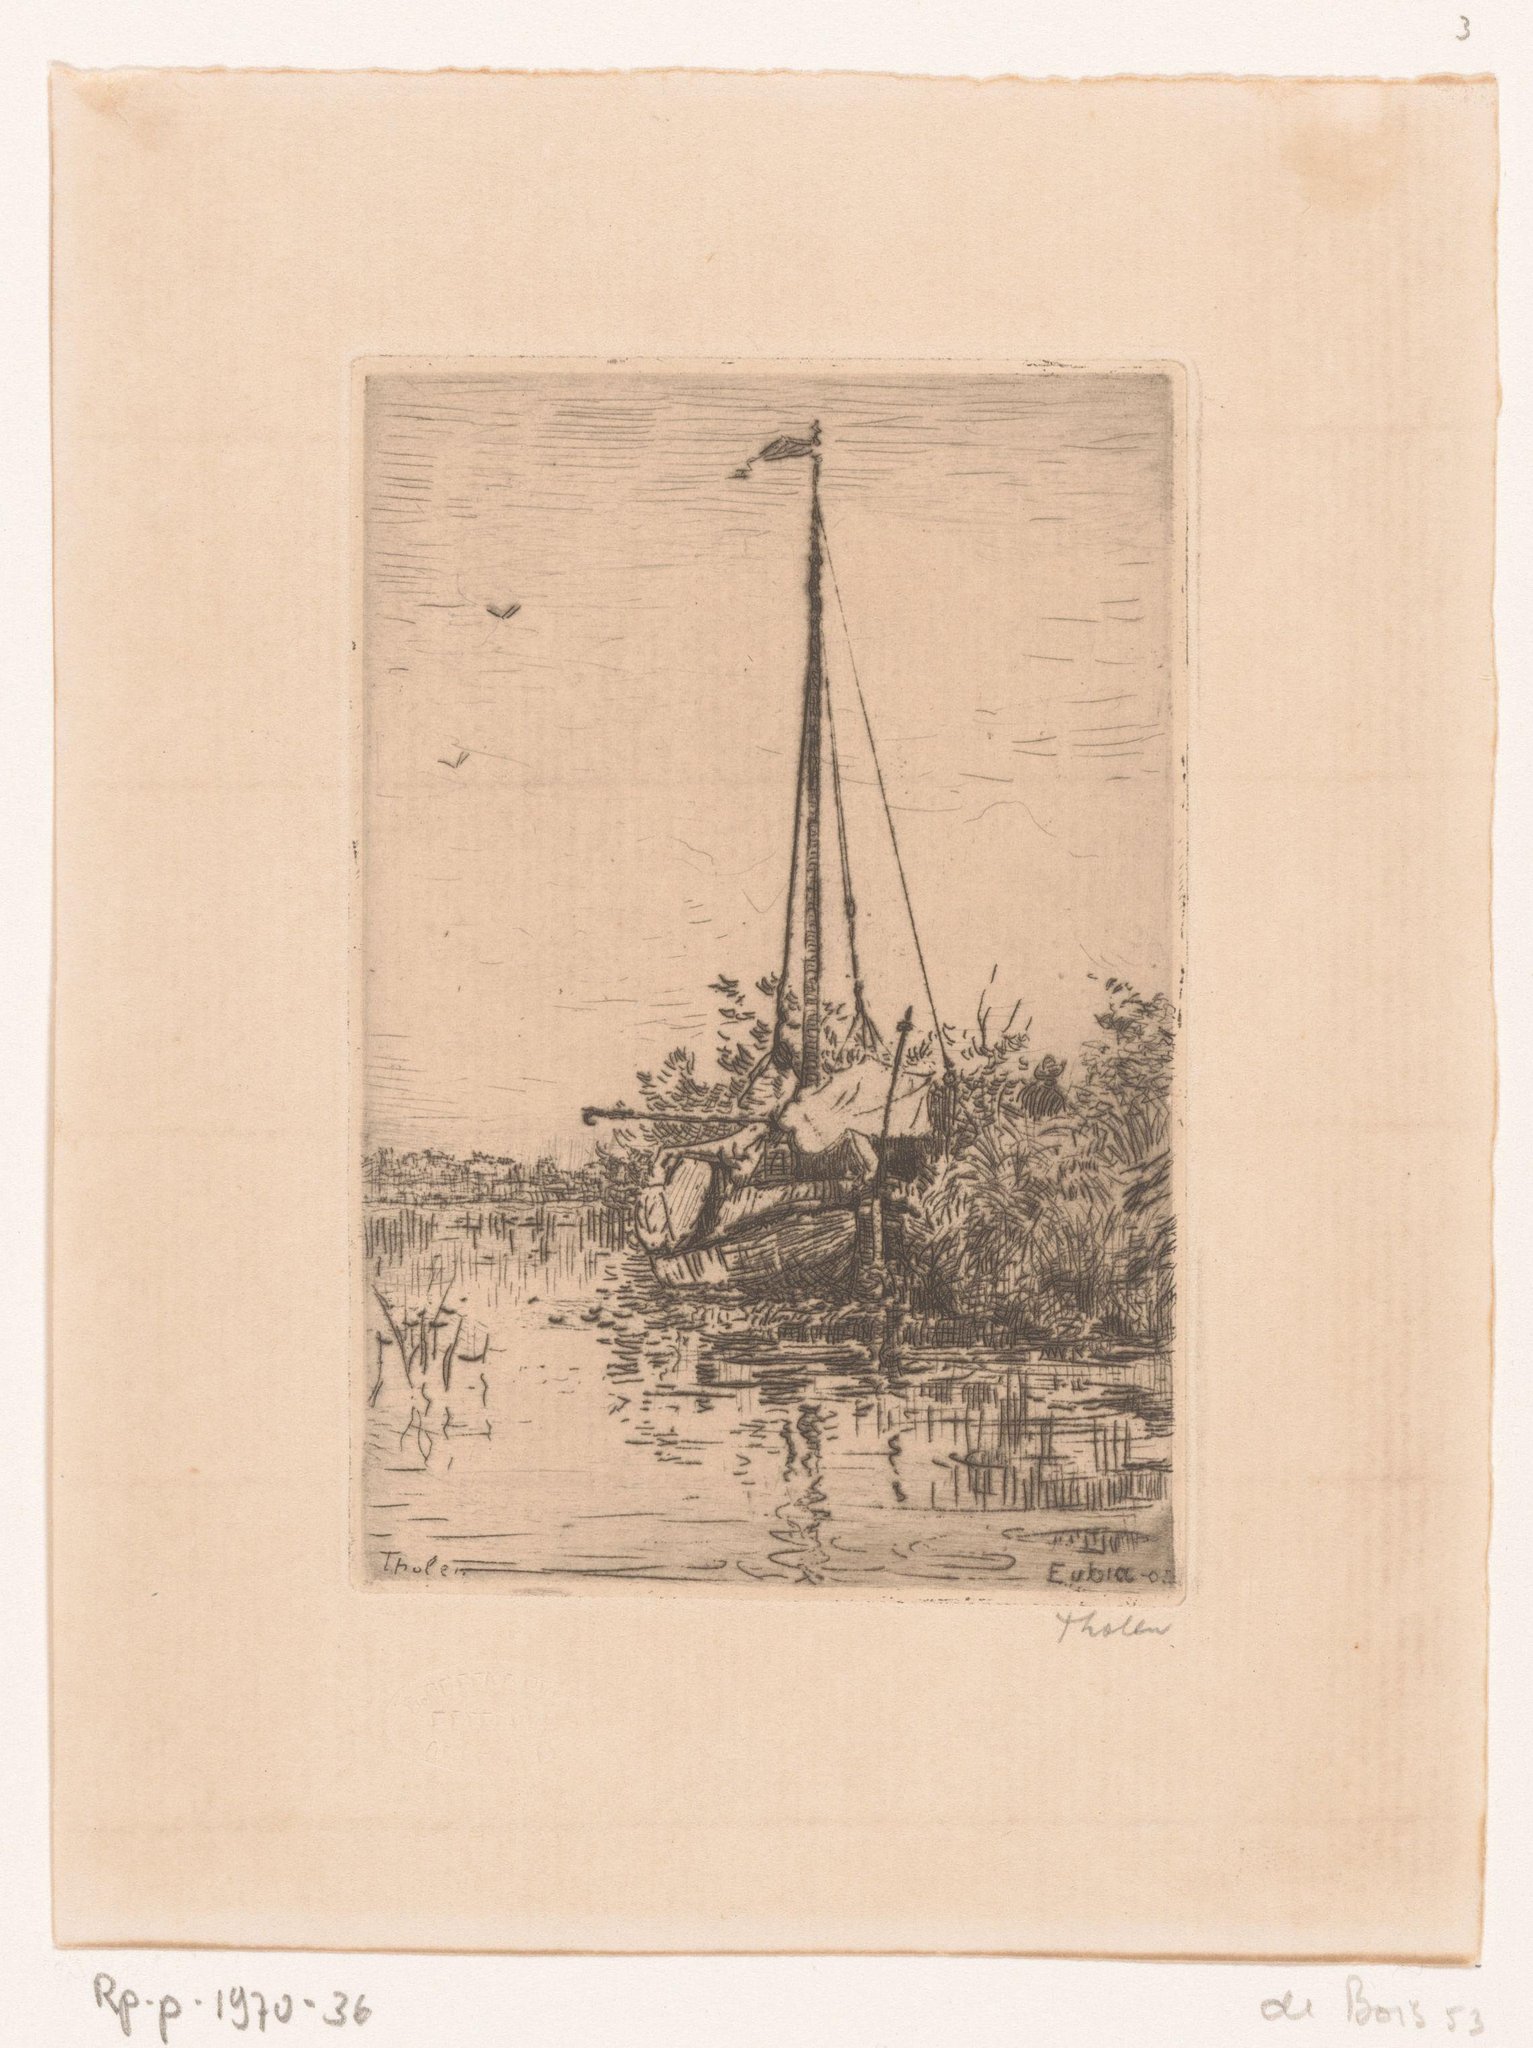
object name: print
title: Aan de Heiligen Ganges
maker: marius bauer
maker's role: draughtsman, print maker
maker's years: 1867-1932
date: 1912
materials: paper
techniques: etching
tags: temple, shrine ~ hinduism, buddhism, jainism, ritual practices ~ hinduism, buddhism, jainism, washing and bathing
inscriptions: collector's mark: Lugt 2760, inscription: ‘1e staat’, inscription: ‘Staat.’, collector's mark: Lugt 2228